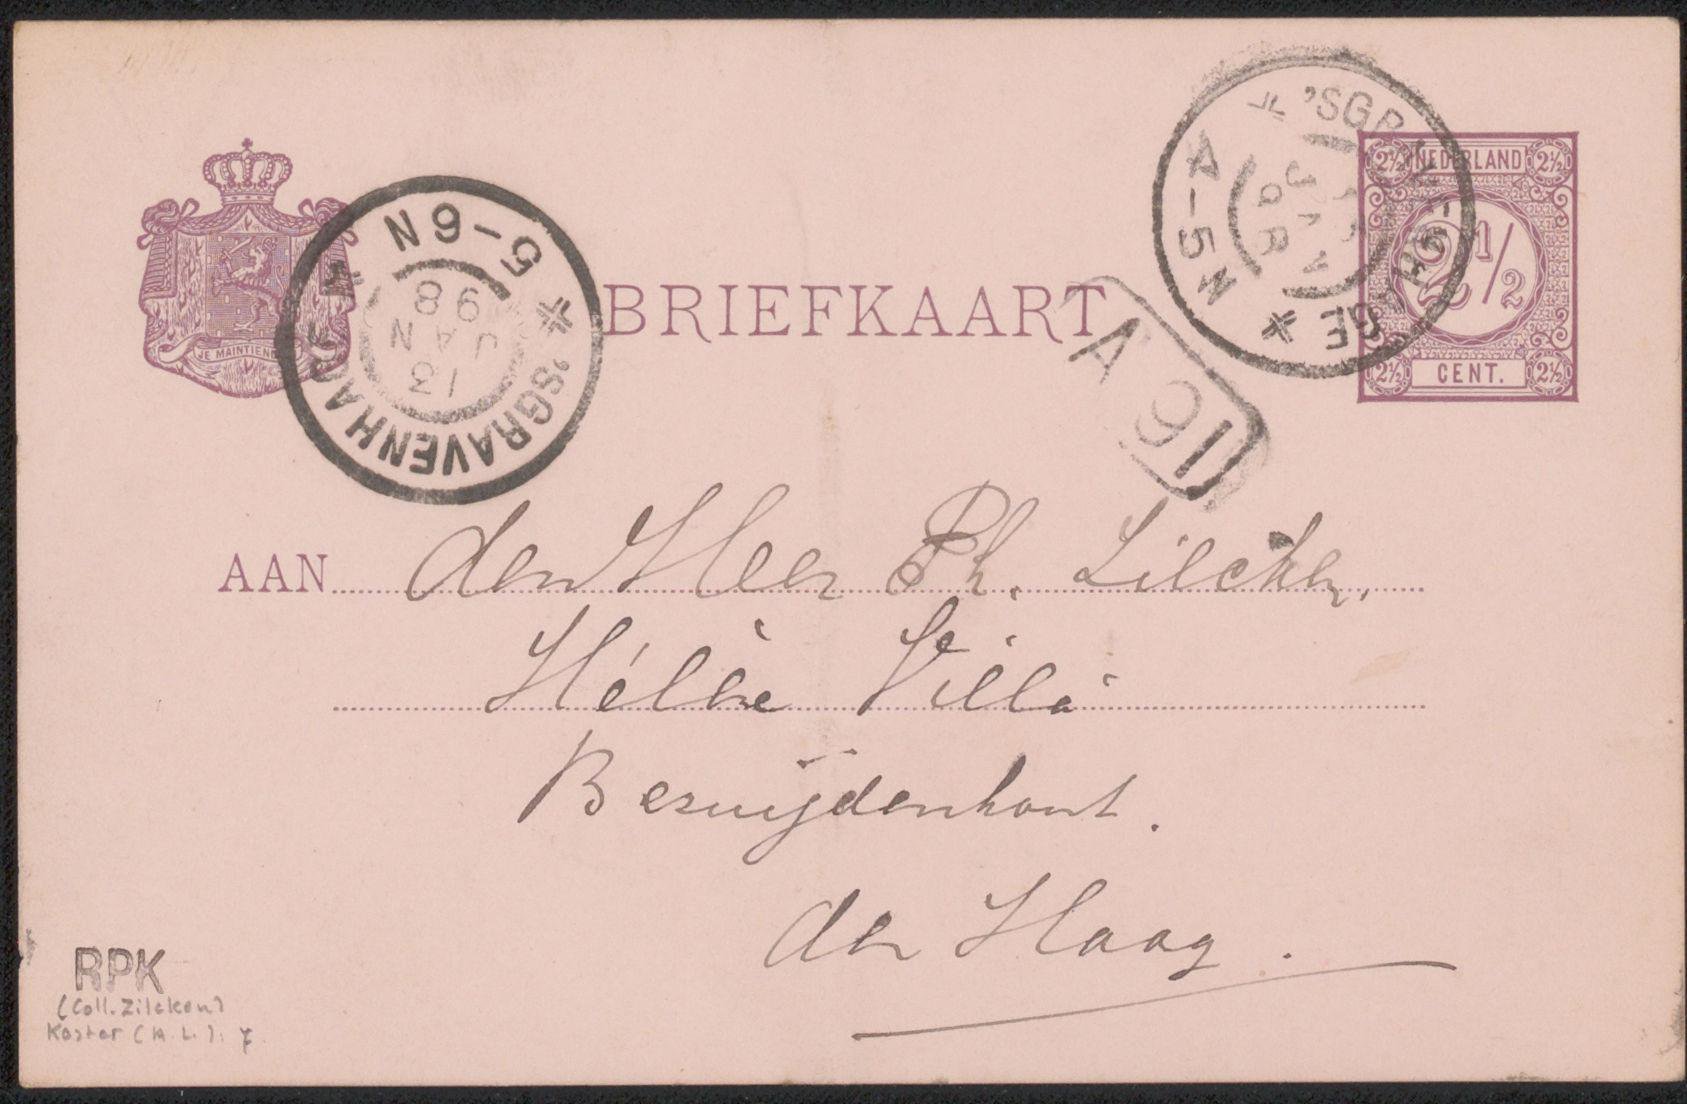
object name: postcard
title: Briefkaart aan Philip Zilcken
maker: anton l. koster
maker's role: draughtsman, painter, print maker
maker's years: 1859-1937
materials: cardboard, ink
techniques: pen, writing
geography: the hague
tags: the hague, philip zilcken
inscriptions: collector's mark: ‘RPK’